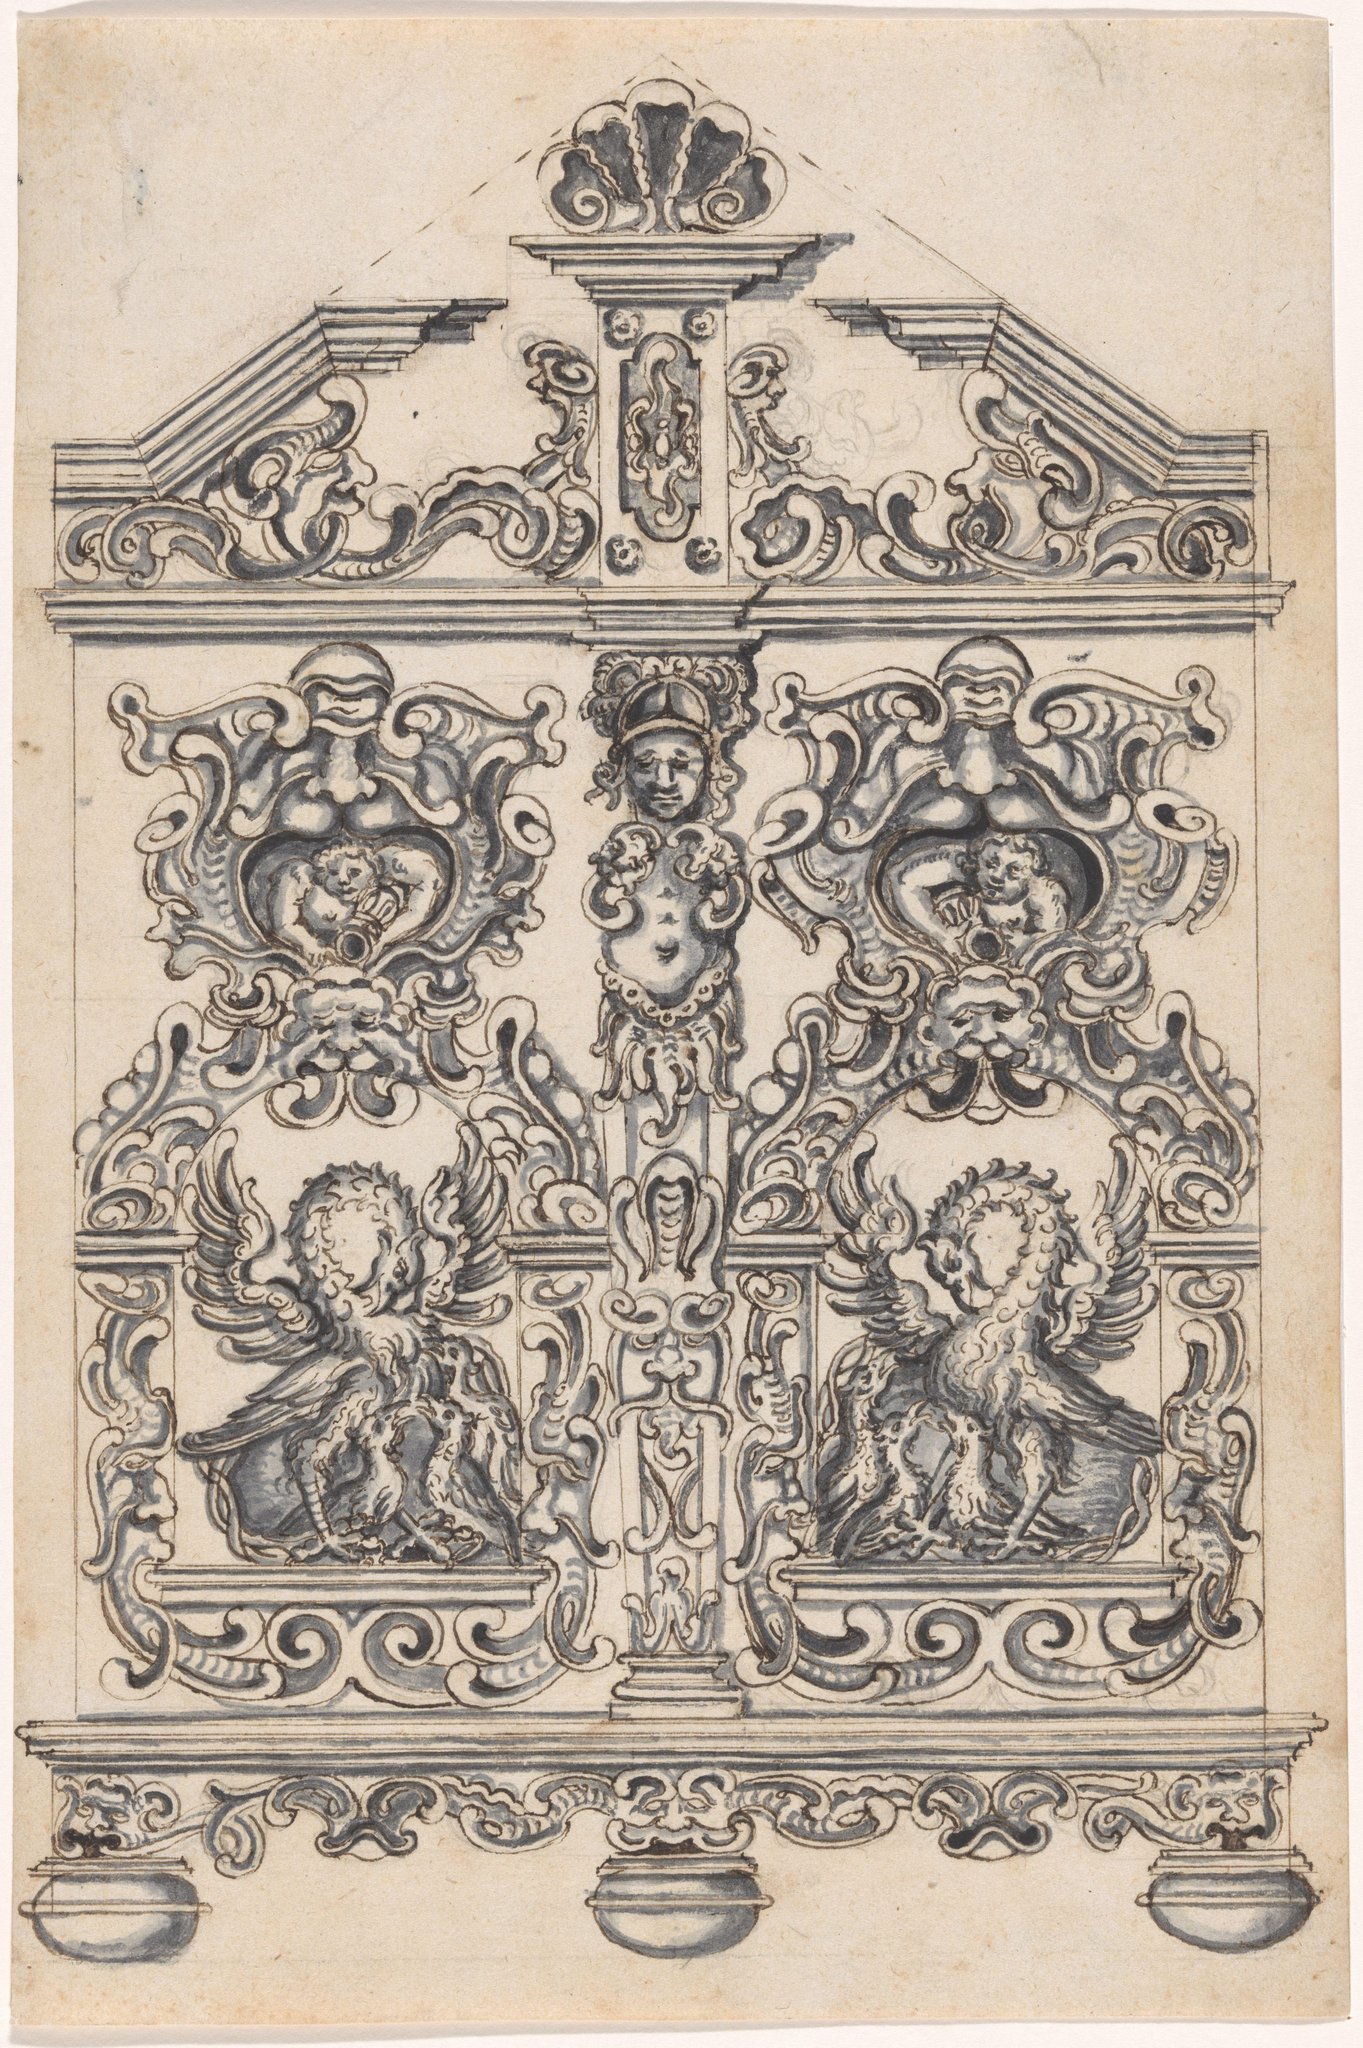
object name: design drawing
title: Tweedeurskast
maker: Anonymous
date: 1660-1680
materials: graphite, ink, paper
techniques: brush, pen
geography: southern germany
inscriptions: inscription: ‘Georg-Kaspar Erasmus / Schreiner i. Nürnberg ca 1660’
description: Tweedeurskast met twee pelikanen die hun borst openpikken om drie jongen te voeden en twee mannen met kruiken, omgeven door kwabornament.